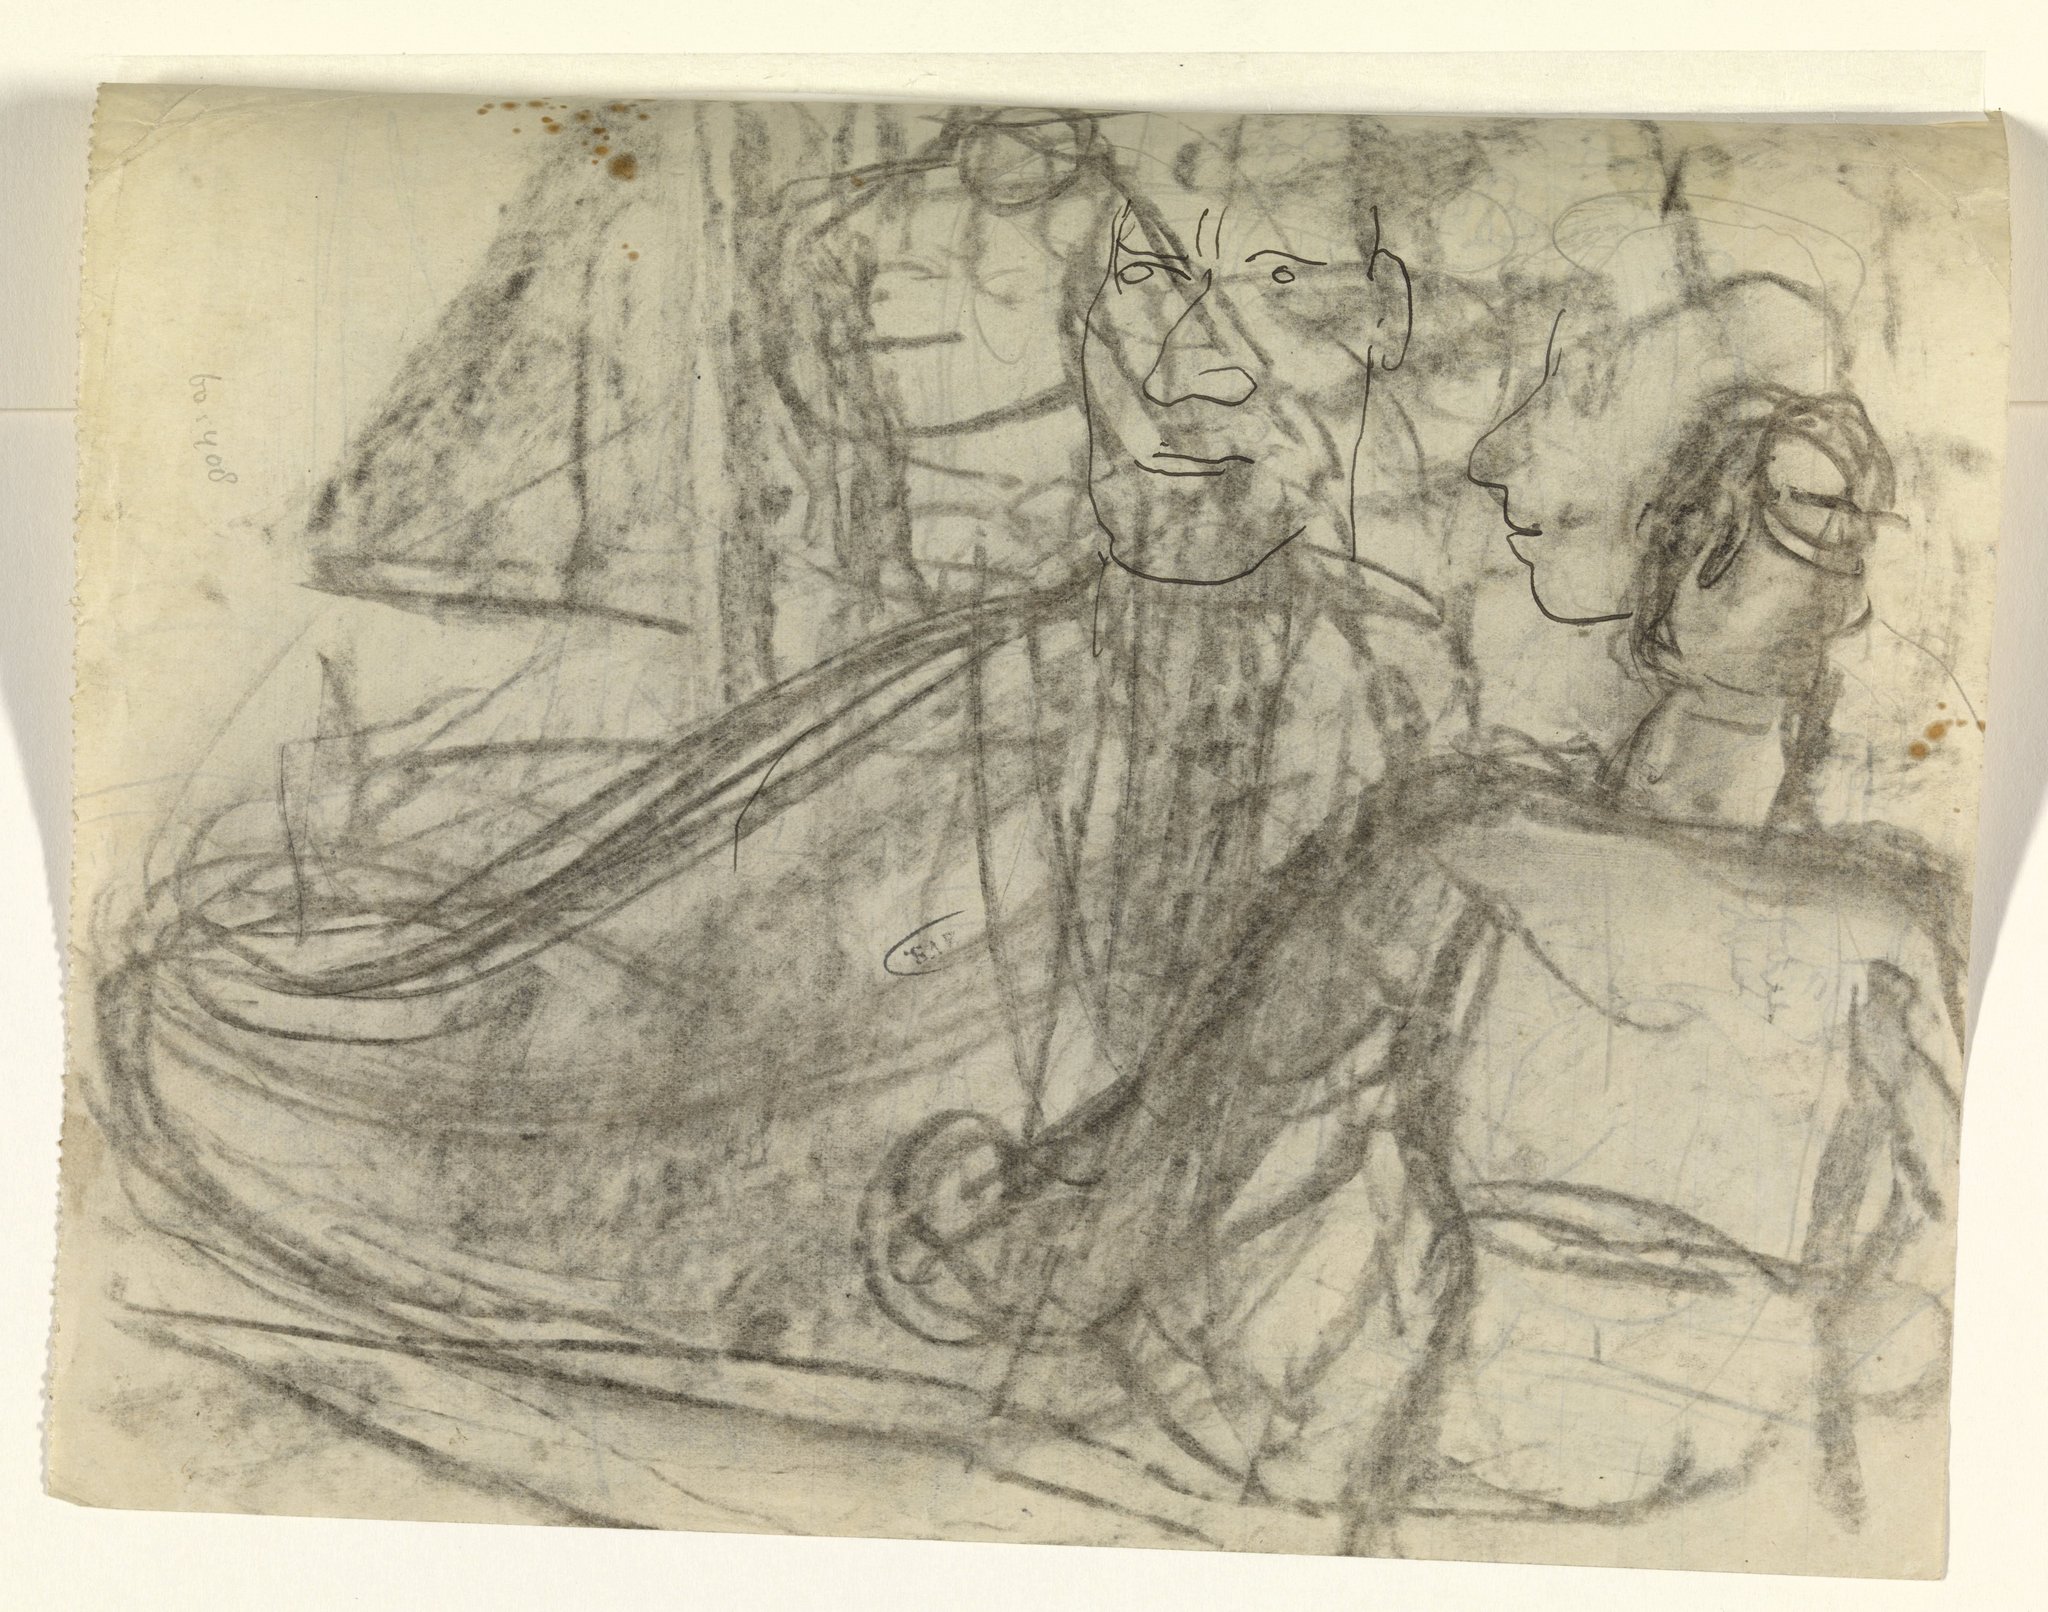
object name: drawing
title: Schip en figuren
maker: leo gestel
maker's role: draughtsman, print maker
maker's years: 1881-1941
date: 1891-1941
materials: charcoal, ink, pencil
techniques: pen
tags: ships (in general), male sex; man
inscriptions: collector's mark: Lugt 2228